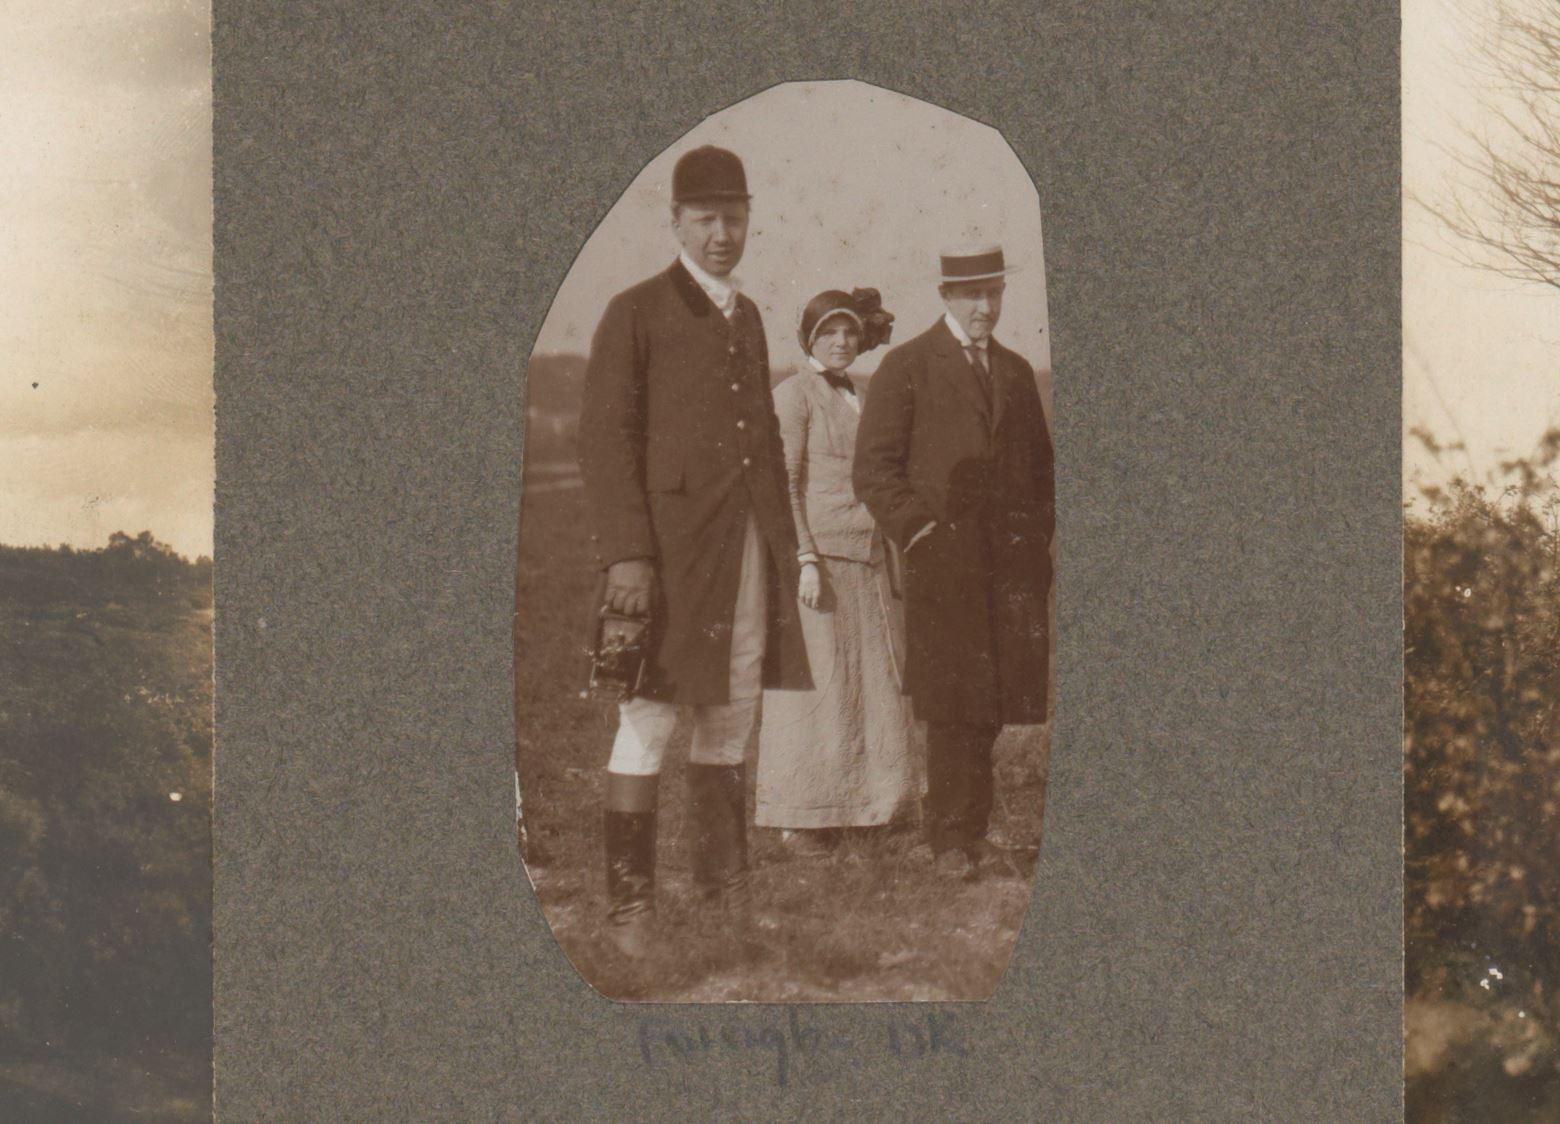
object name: album leaf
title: Ruitertafereel op Koninklijke Houtvesterij Het Loo: ruiter, man en vrouw staand op een hei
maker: Anonymous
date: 1900-1925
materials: photographic support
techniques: collodion silver print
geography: het loo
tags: hunting, chase, hunting-ground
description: Onderdeel van Fotoalbum van de heer Brams, opperhoutvester van koningin Wilhelmina op Koninklijke Houtvesterij Het Loo.